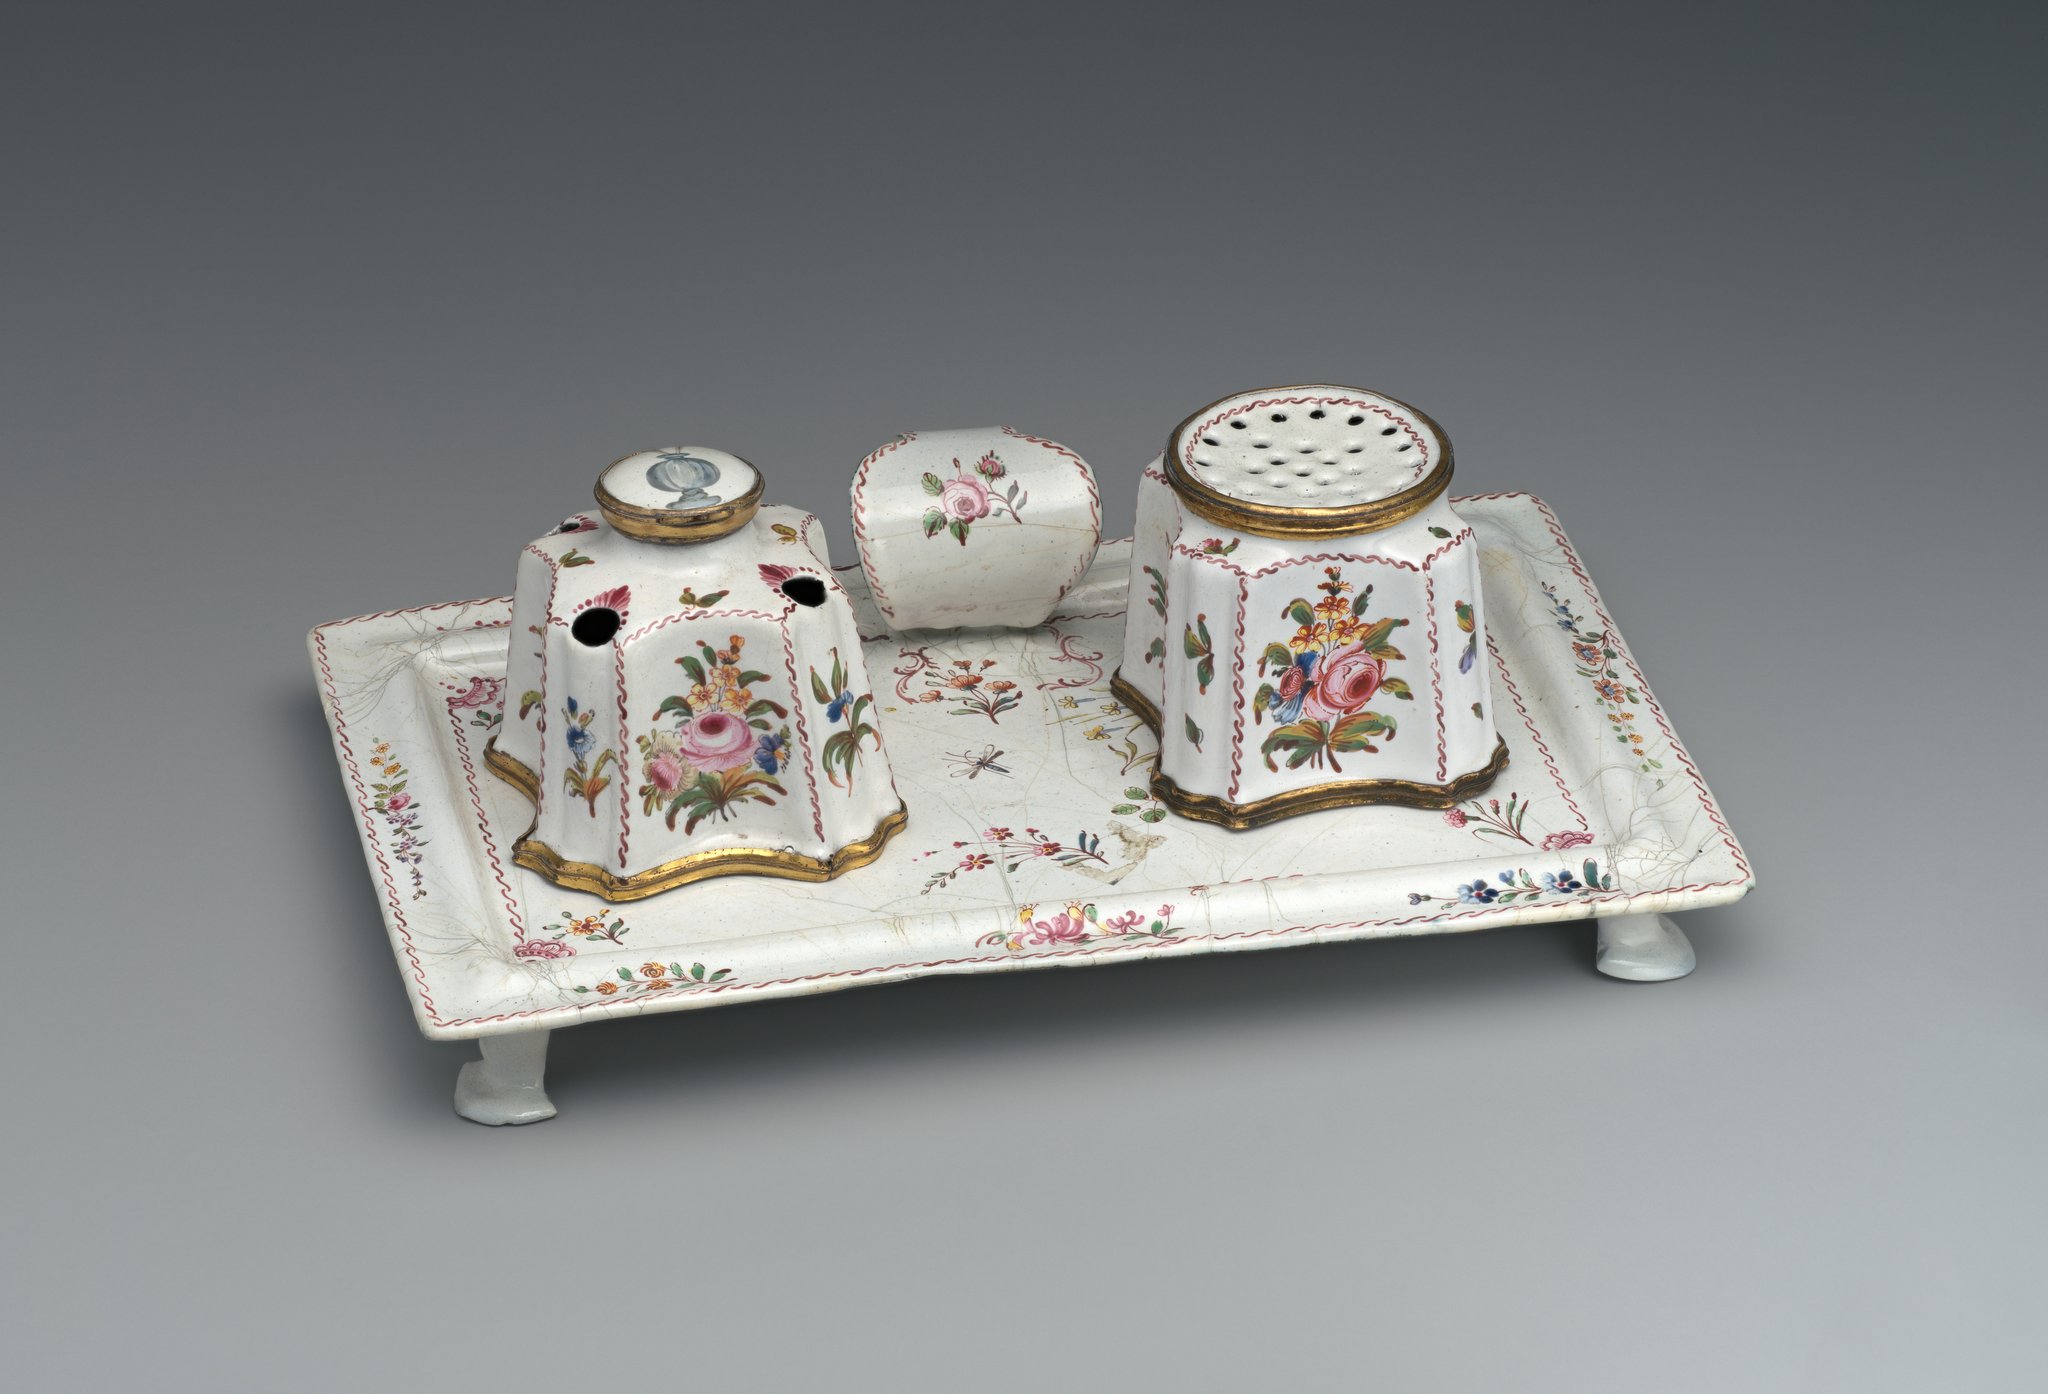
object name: desk set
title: Desk set with inkwell and pounce pot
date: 1765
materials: copper, enamel